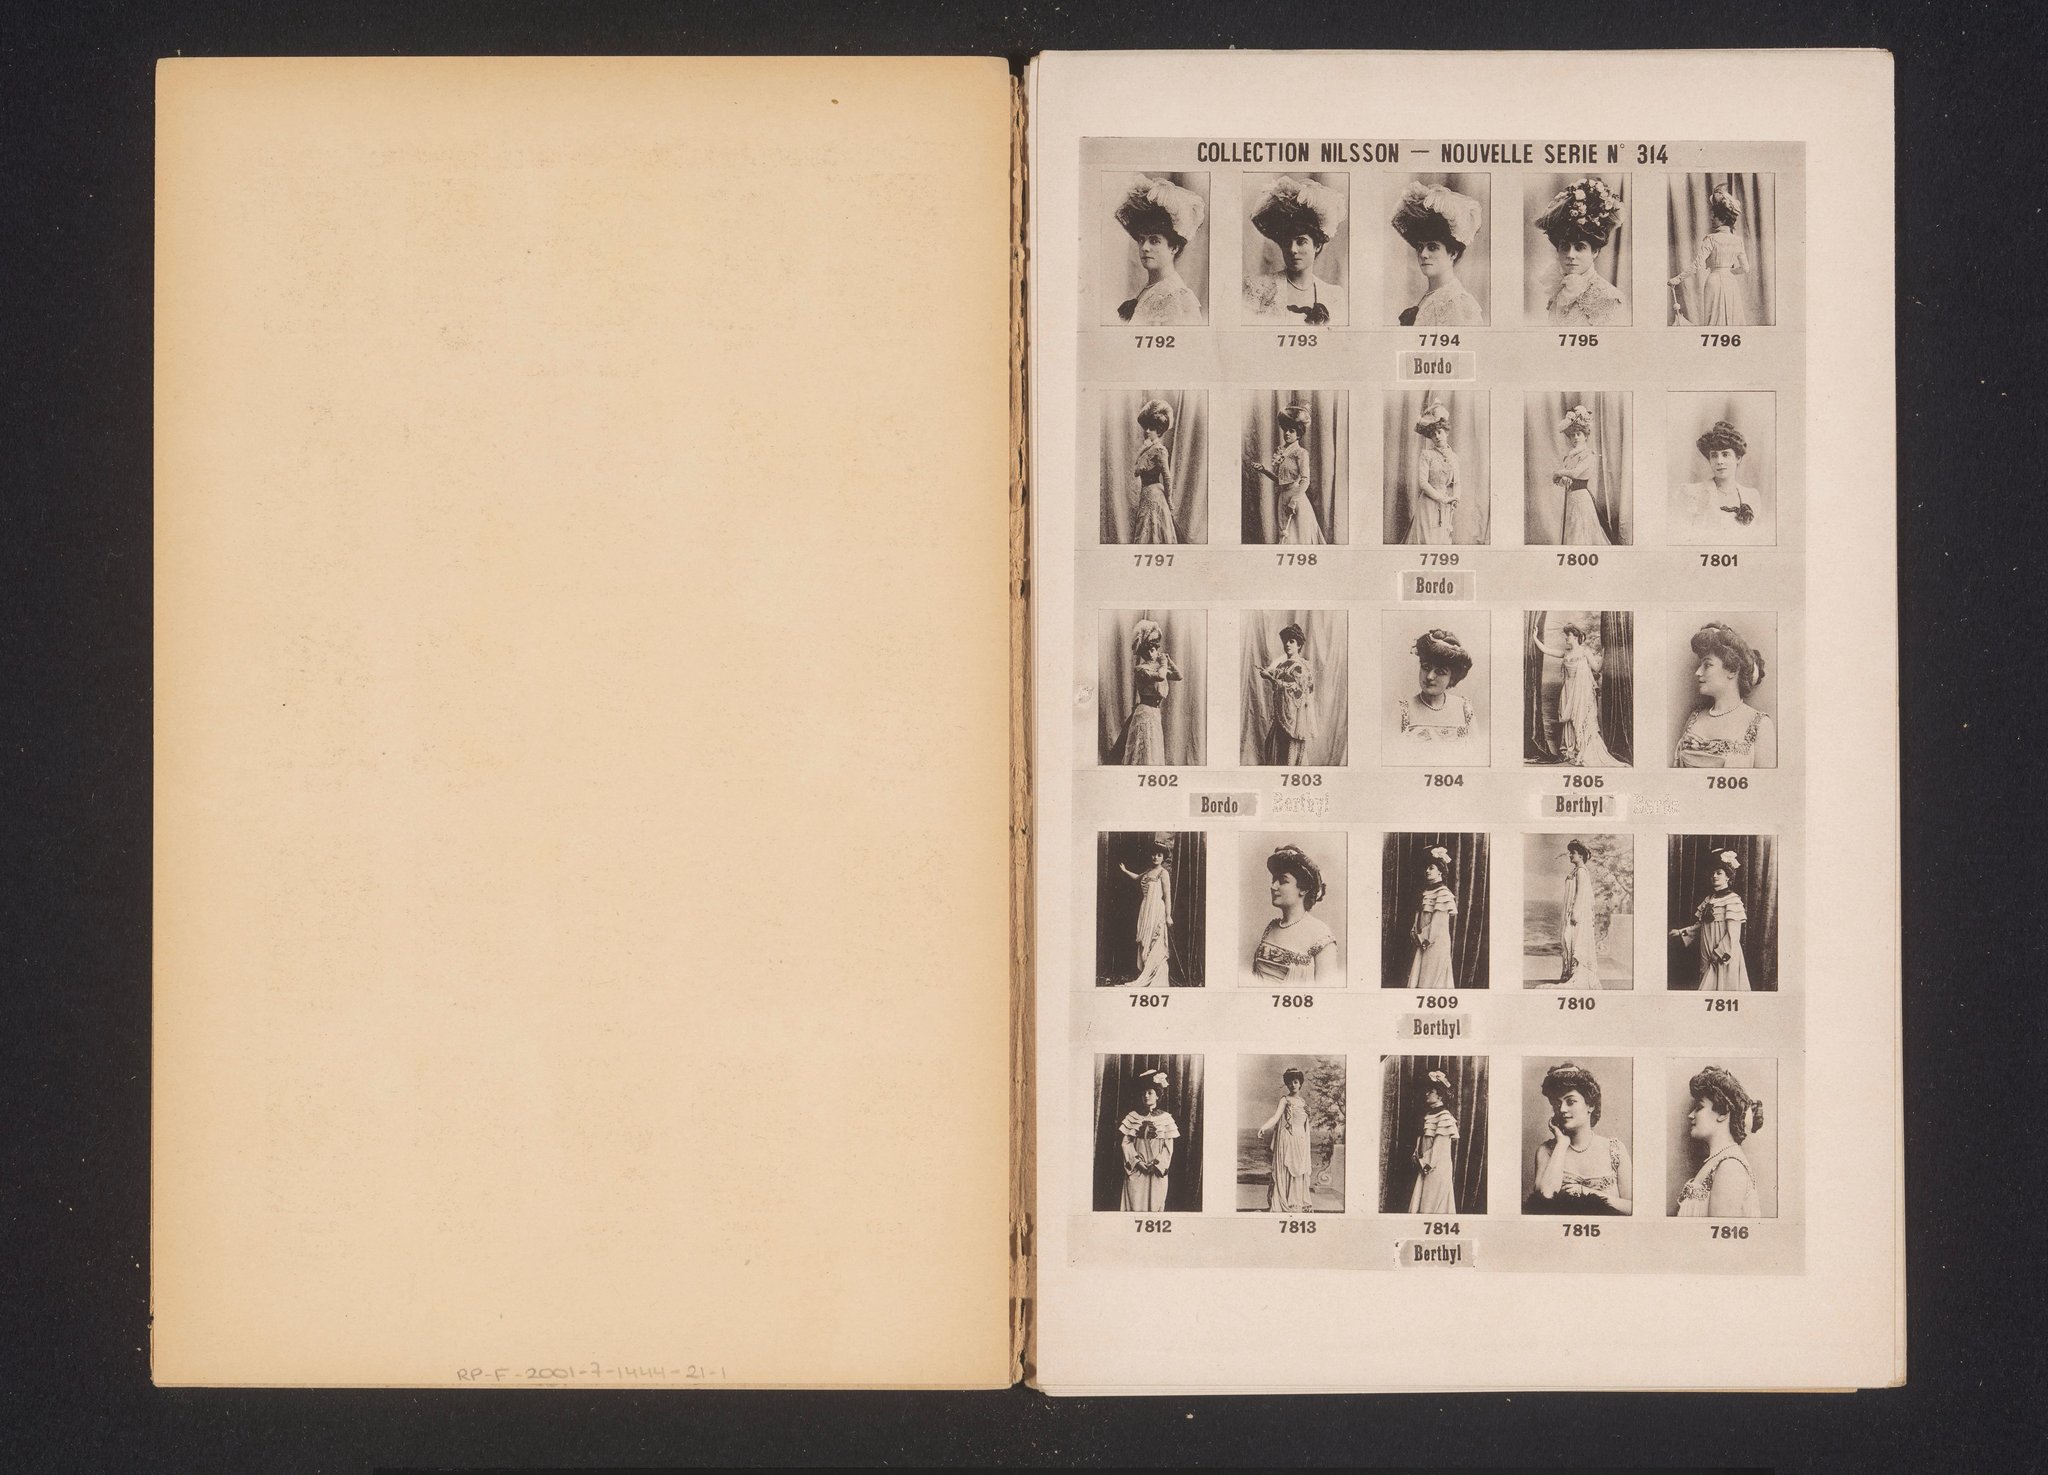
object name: photomechanical print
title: Collection Nilsson - Nouvelle Série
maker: Anonymous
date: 1895-1900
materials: paper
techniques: photograph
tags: historical persons - bb - woman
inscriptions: number: ‘No 314’